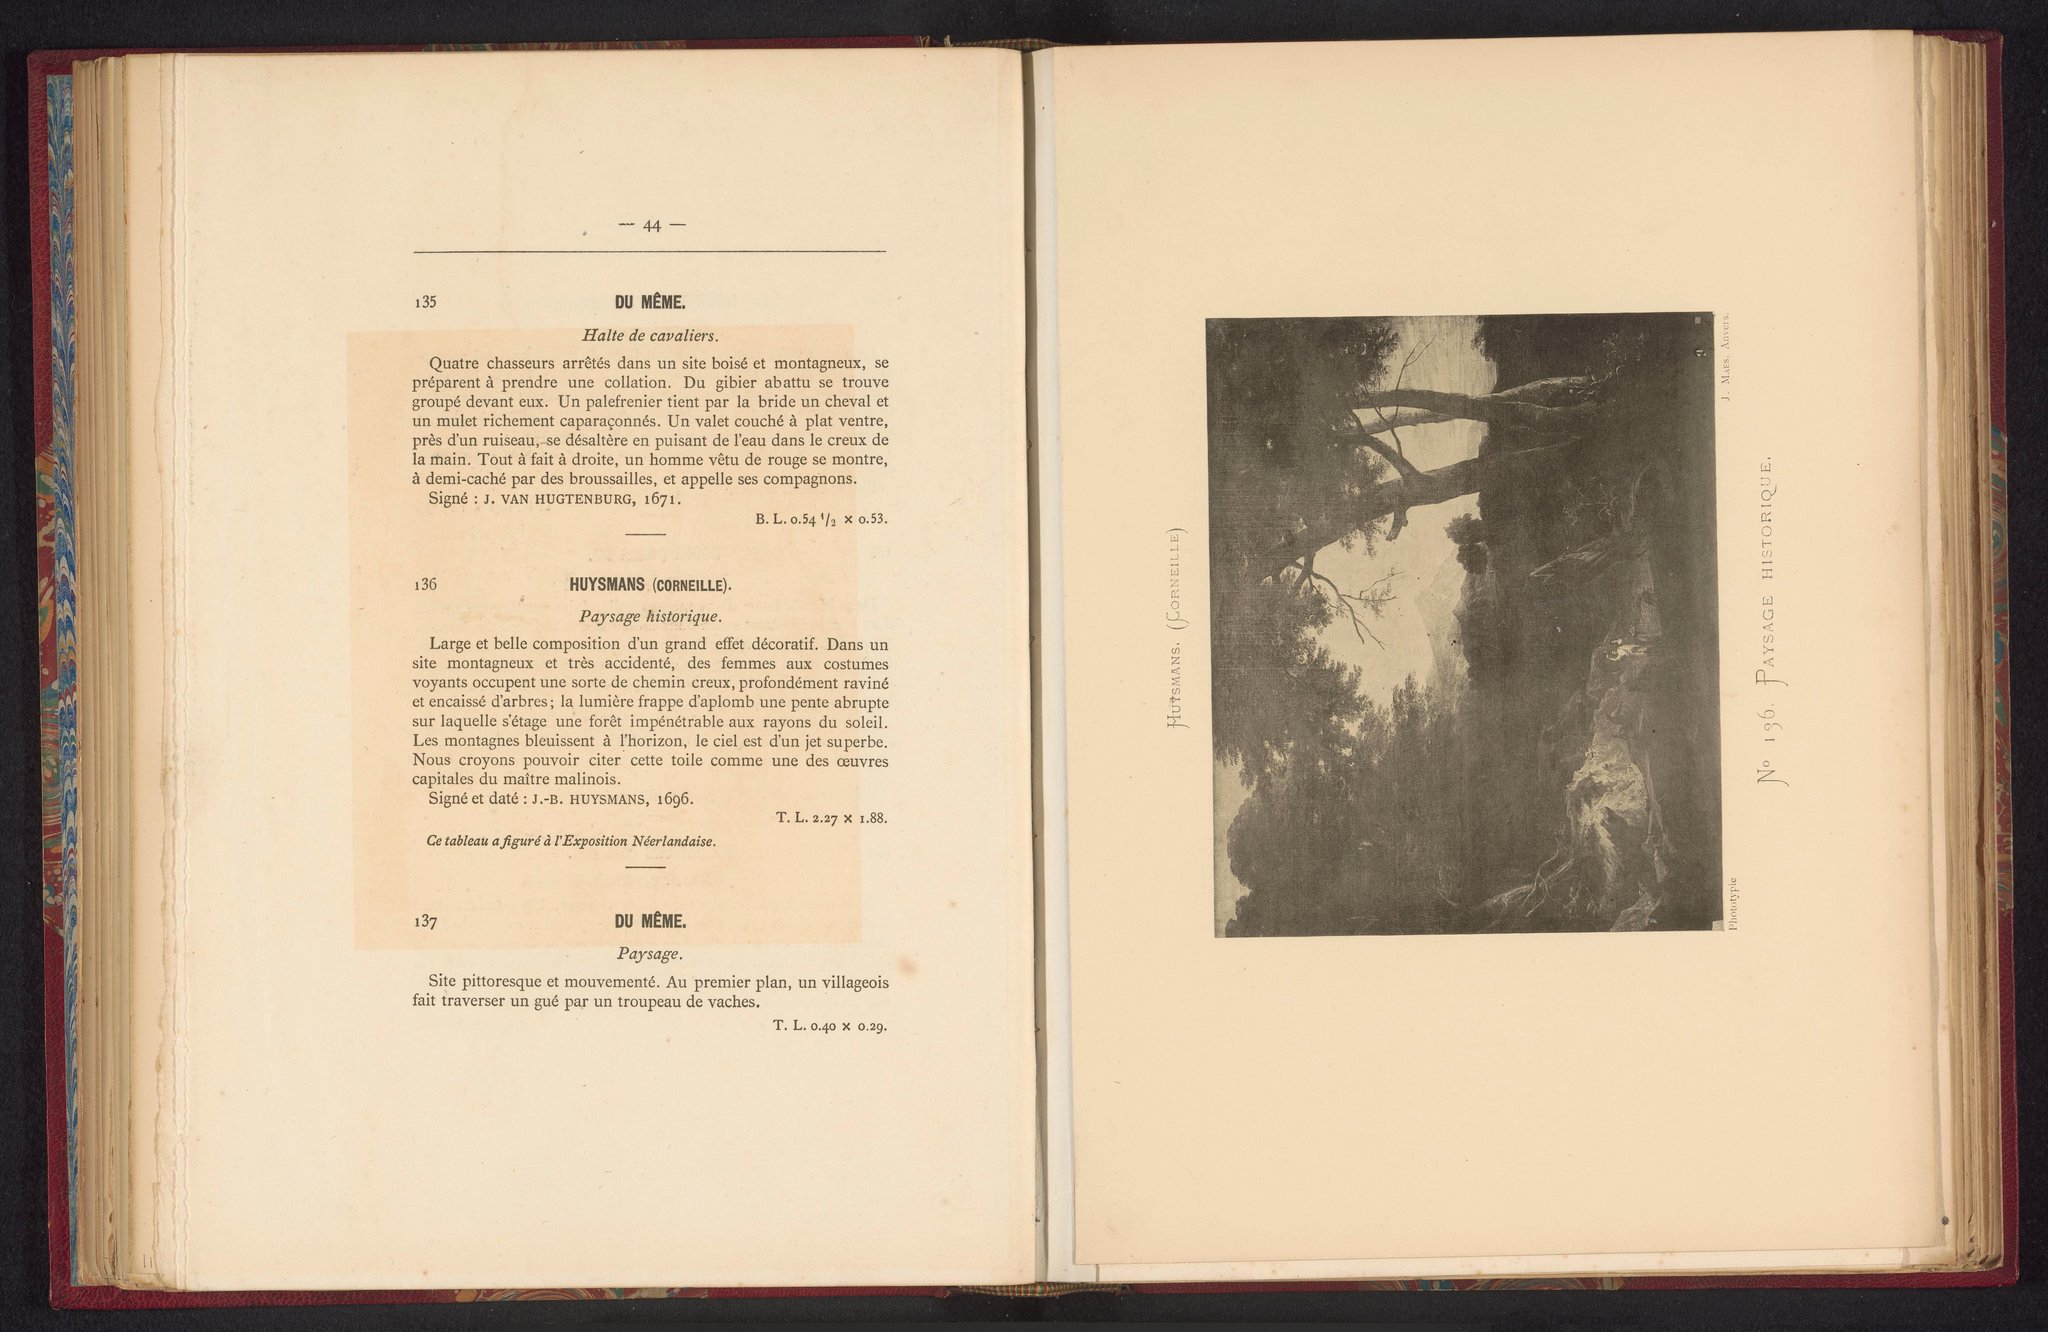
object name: photomechanical print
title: Reproductie van een geschilderd landschap van Constantinus Cornelus Huysmans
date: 1878-1883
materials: paper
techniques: photograph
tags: landscapes, historical persons, painting, drawing and the graphic arts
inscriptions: number: ‘No. 136’